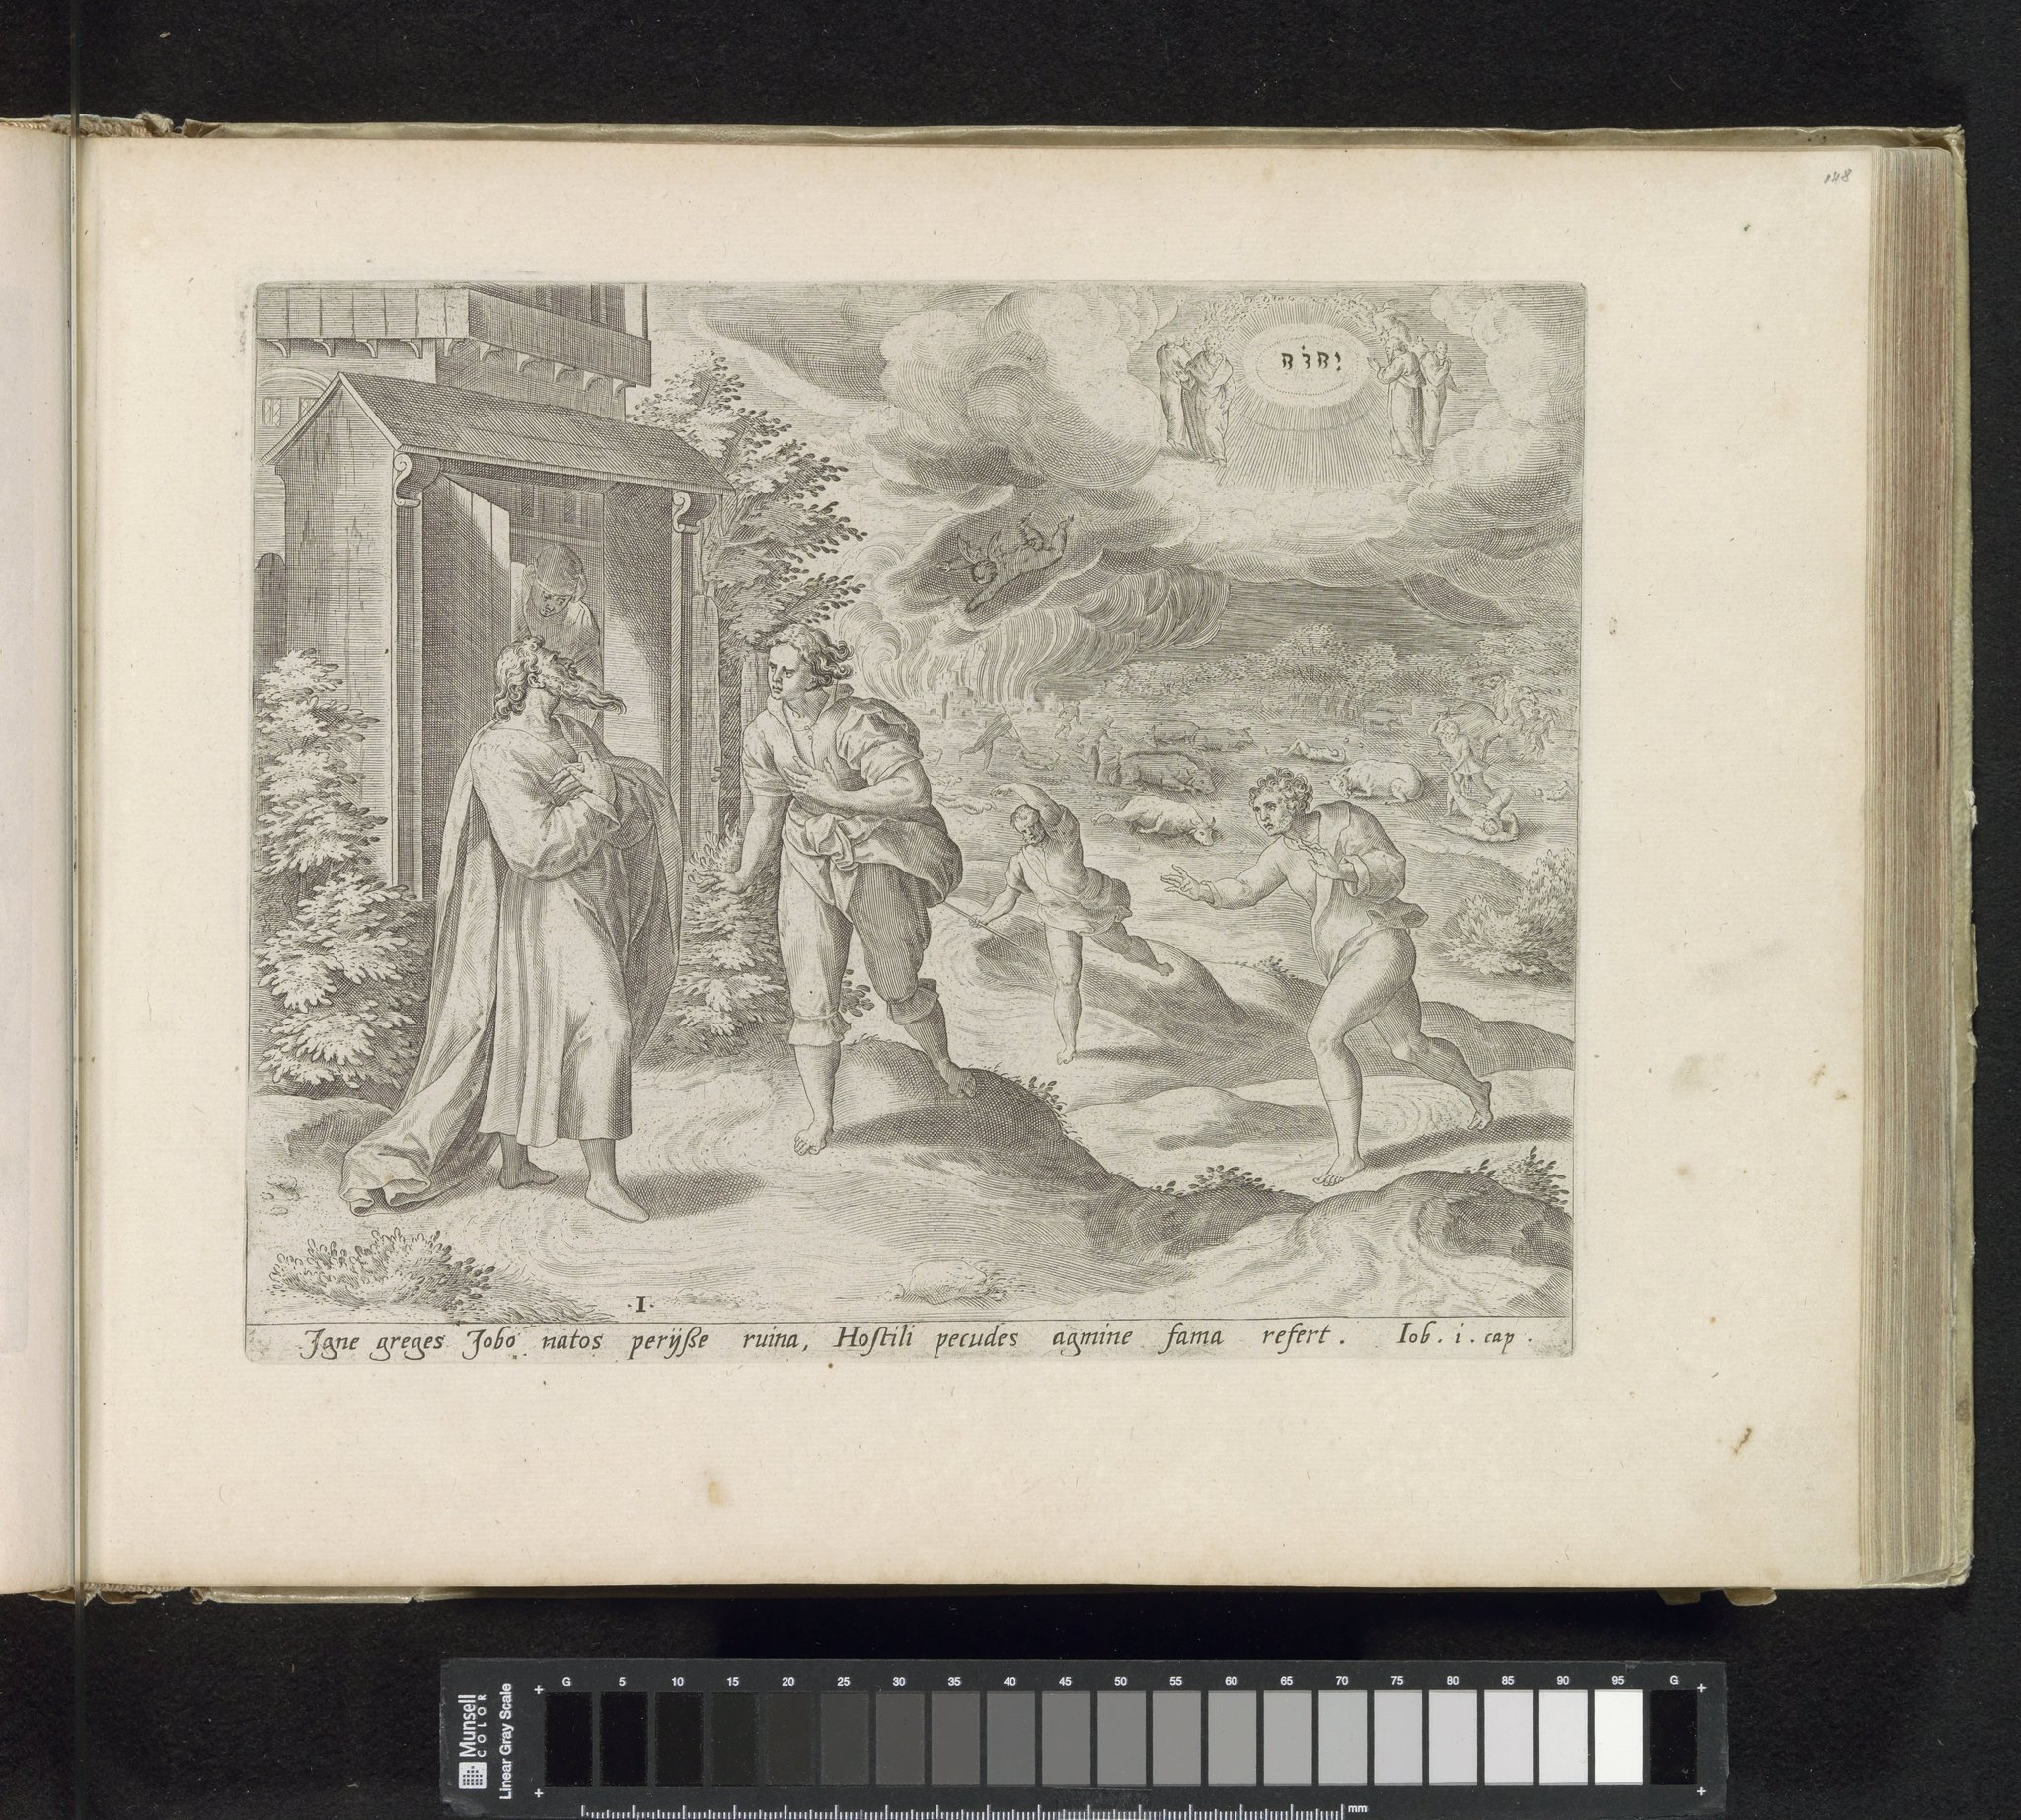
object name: print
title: Thesaurus sacrarum historiaru[m] veteris testame[n]ti, elega[n]tissimis imaginibus expressu[m] excelle[n]tissimoru[m] in hac arte viroru[m] opera: nu[n]c primu[m] in luce[m] editus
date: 1585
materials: paper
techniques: engraving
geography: antwerp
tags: the 'sons of god' (angels) with satan gather before god (job 1:6-12), messengers present themselves to job, each reporting a new disaster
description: Job hoort van drie boodschappers over het onheil dat hem is overkomen. In de deuropening staat zijn vrouw, die haar zakdoek voor haar gezicht houdt. In het landschap is te zien hoe Jobs vee en kamelen worden gestolen, hoe zijn herders en vee zijn omgekomen door de bliksem en hoe het huis in de stad links, waarin de kinderen van Job een feest hielden, instort in de storm. Aan de hemel het tetragram, als symbool van God de Vader en de hemelbewoners die hun opwachting maken. Onder de voorstelling een verwijzing in het Latijn naar de Bijbeltekst in Job 1. Deze prent maakt deel uit van een album.